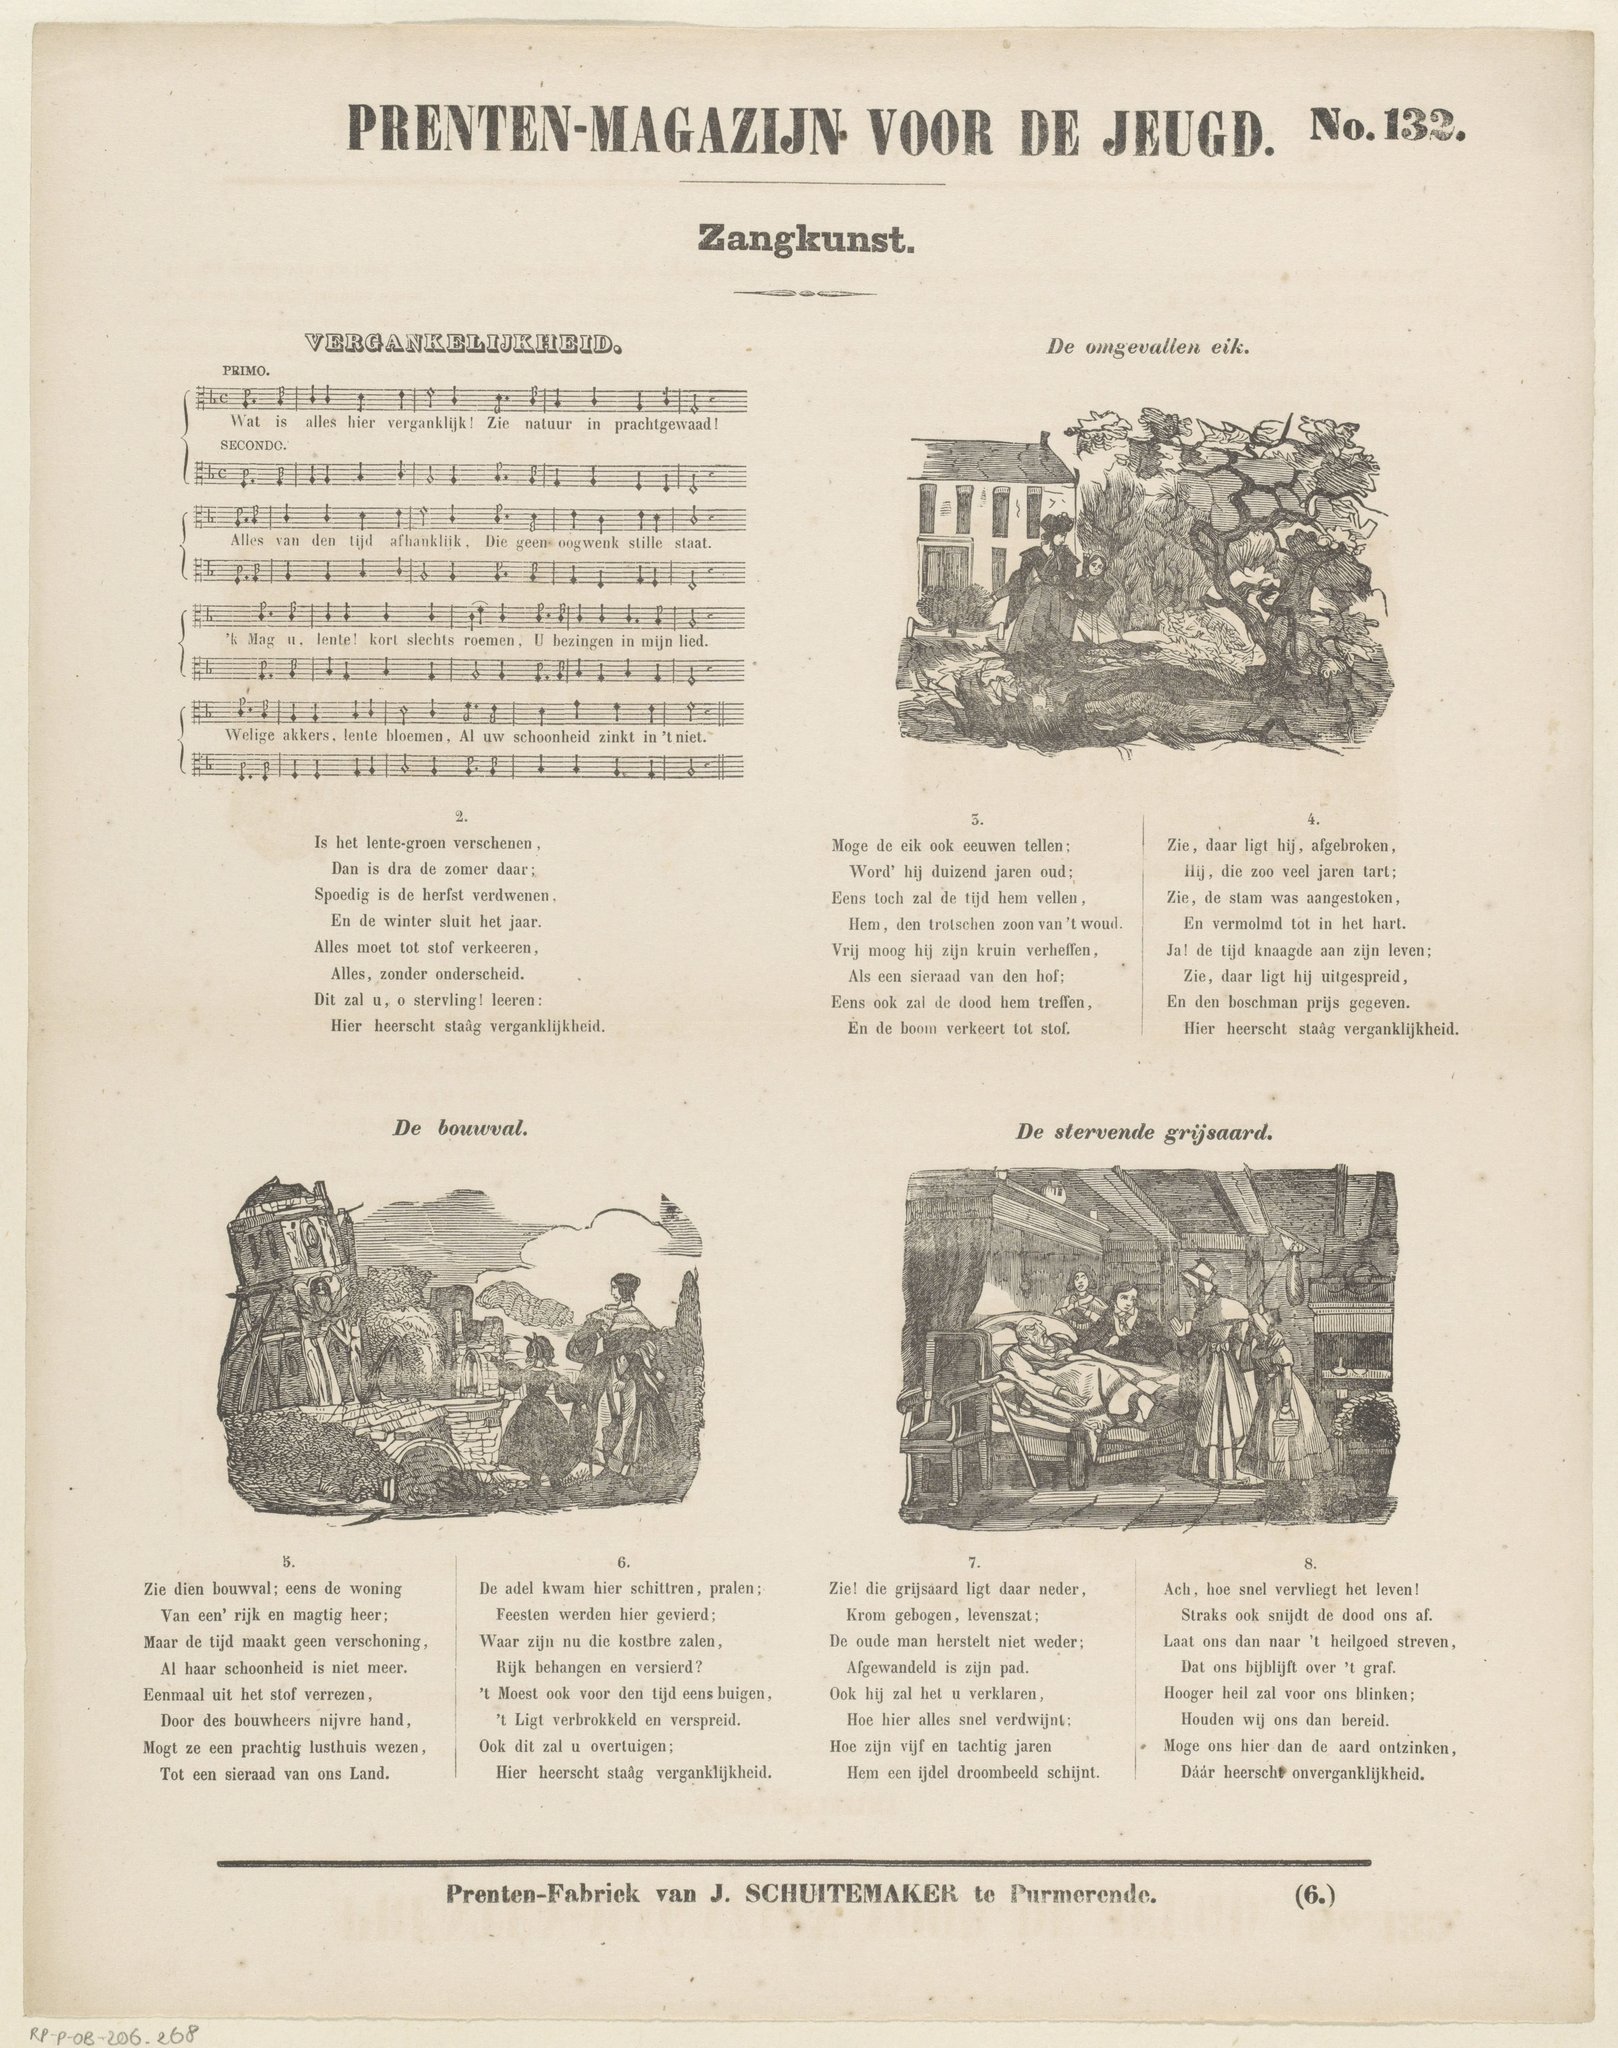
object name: popular print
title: Vergankelijkheid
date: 1850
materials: paper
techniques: letterpress printing, engraving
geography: netherlands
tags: trees: oak, landscape with ruins, old man, dying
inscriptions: collector's mark: Lugt 2760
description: Na voltooiing van de acht jaargangen van de reeks 'Prenten-magazijn voor de jeugd' in 1850 heeft Jan Schuitemaker al deze prenten heruitgegeven en omgenummerd als nr. 1 t/m 192. De oorspronkelijke jaargang wordt telkens nog vermeld rechtsonder op de prent. Binnen de jaargangen zijn prenten van hetzelfde thema in clusters van vier achter elkaar gezet.